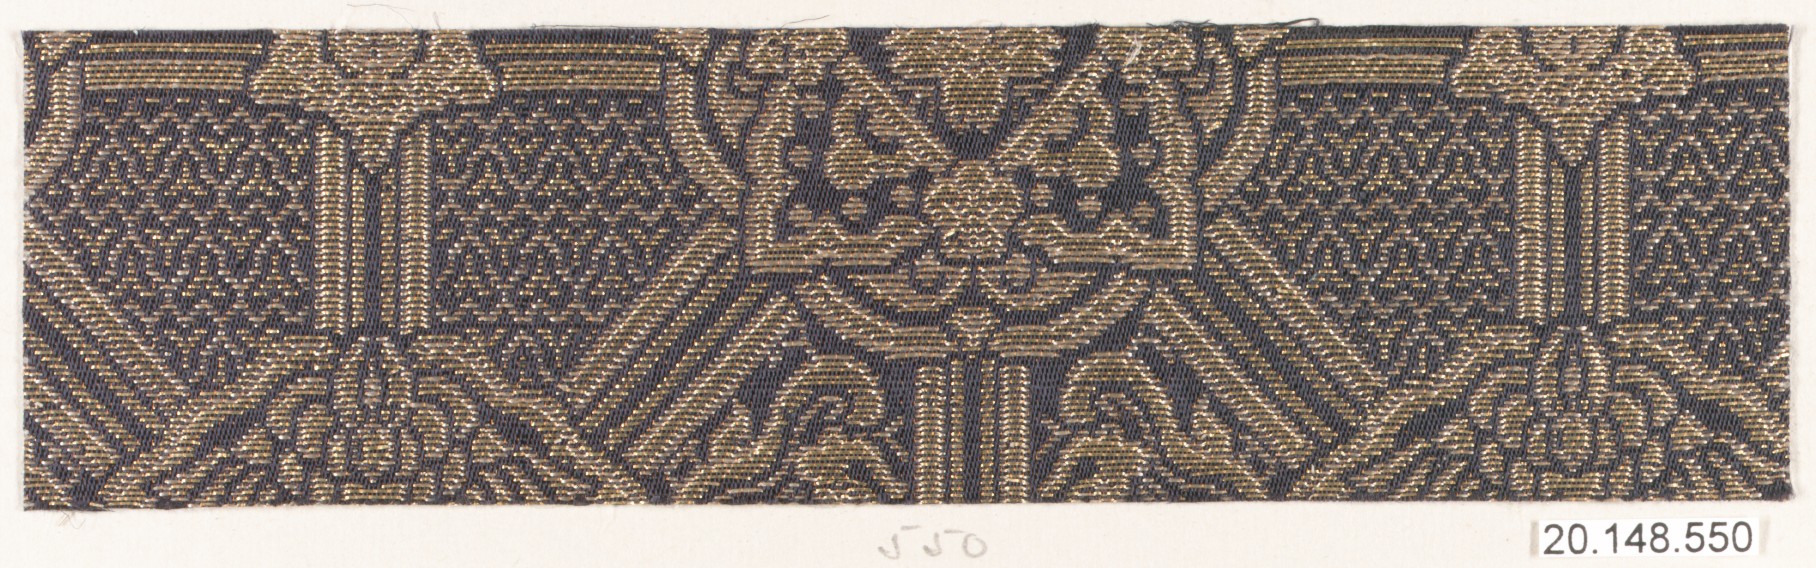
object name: piece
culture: chinese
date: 1701-1800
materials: silk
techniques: compound weave